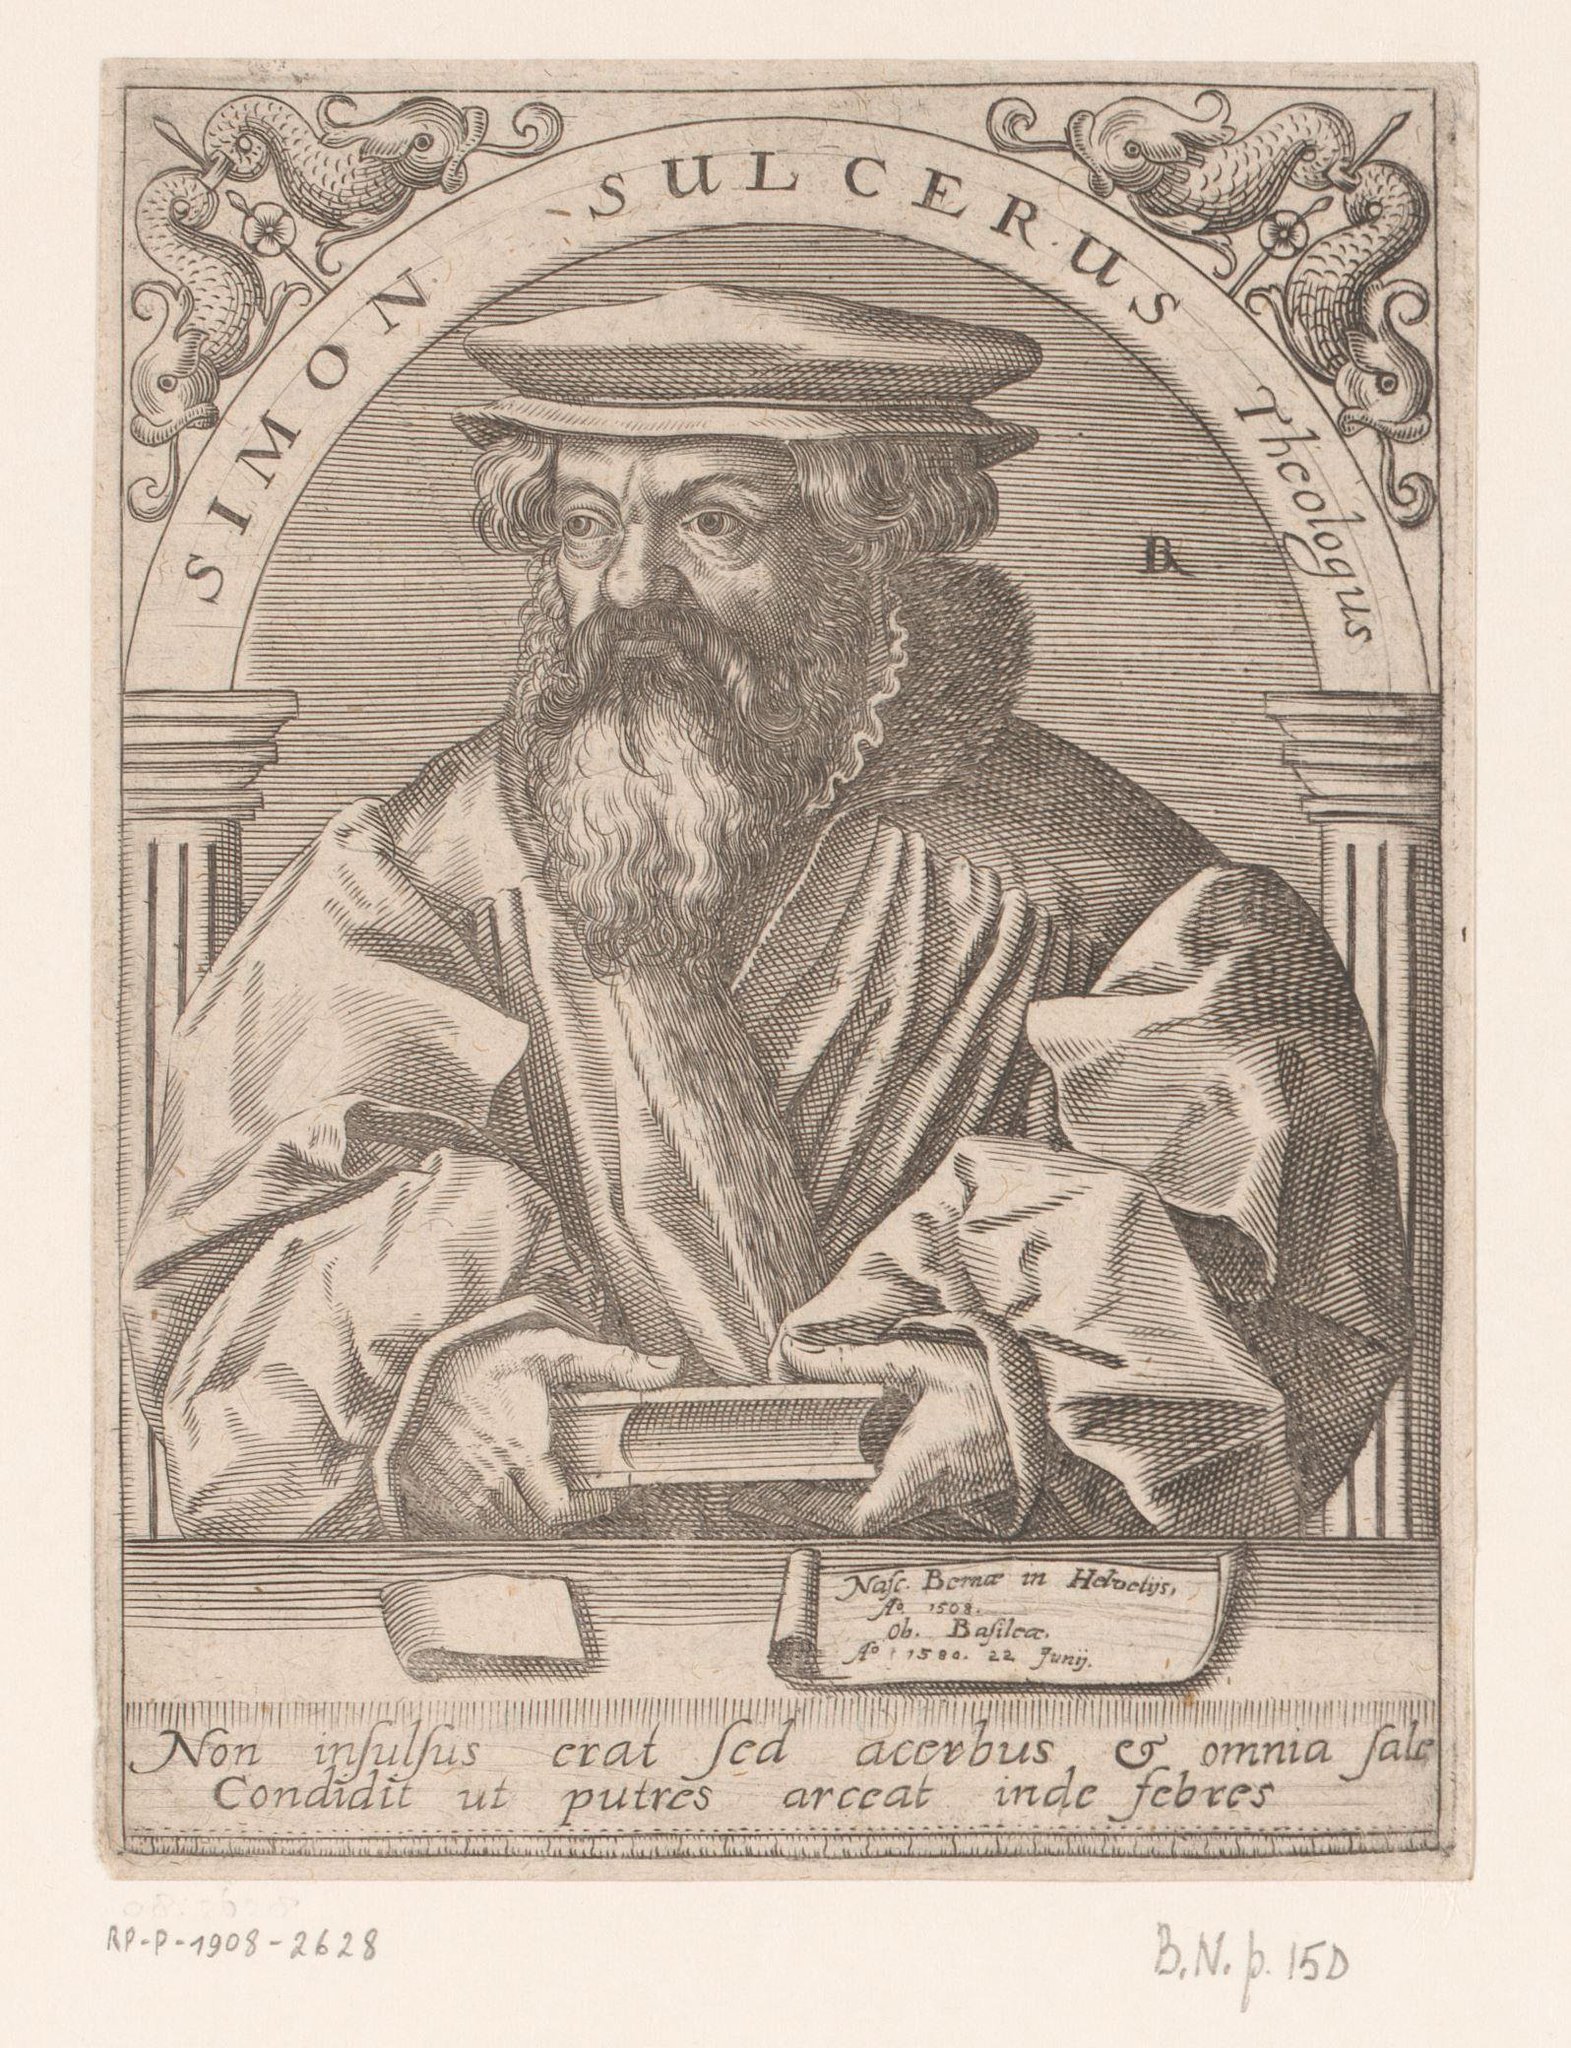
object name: book illustration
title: Simon Sulcerus Theologus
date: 1597-1599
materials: paper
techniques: engraving, letterpress printing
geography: france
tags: historical persons, book, swimming mammals: dolphin - ff - fabulous animals (sometimes wrongly called 'grotesques'); 'mostri' (ripa)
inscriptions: collector's mark: Lugt 2228